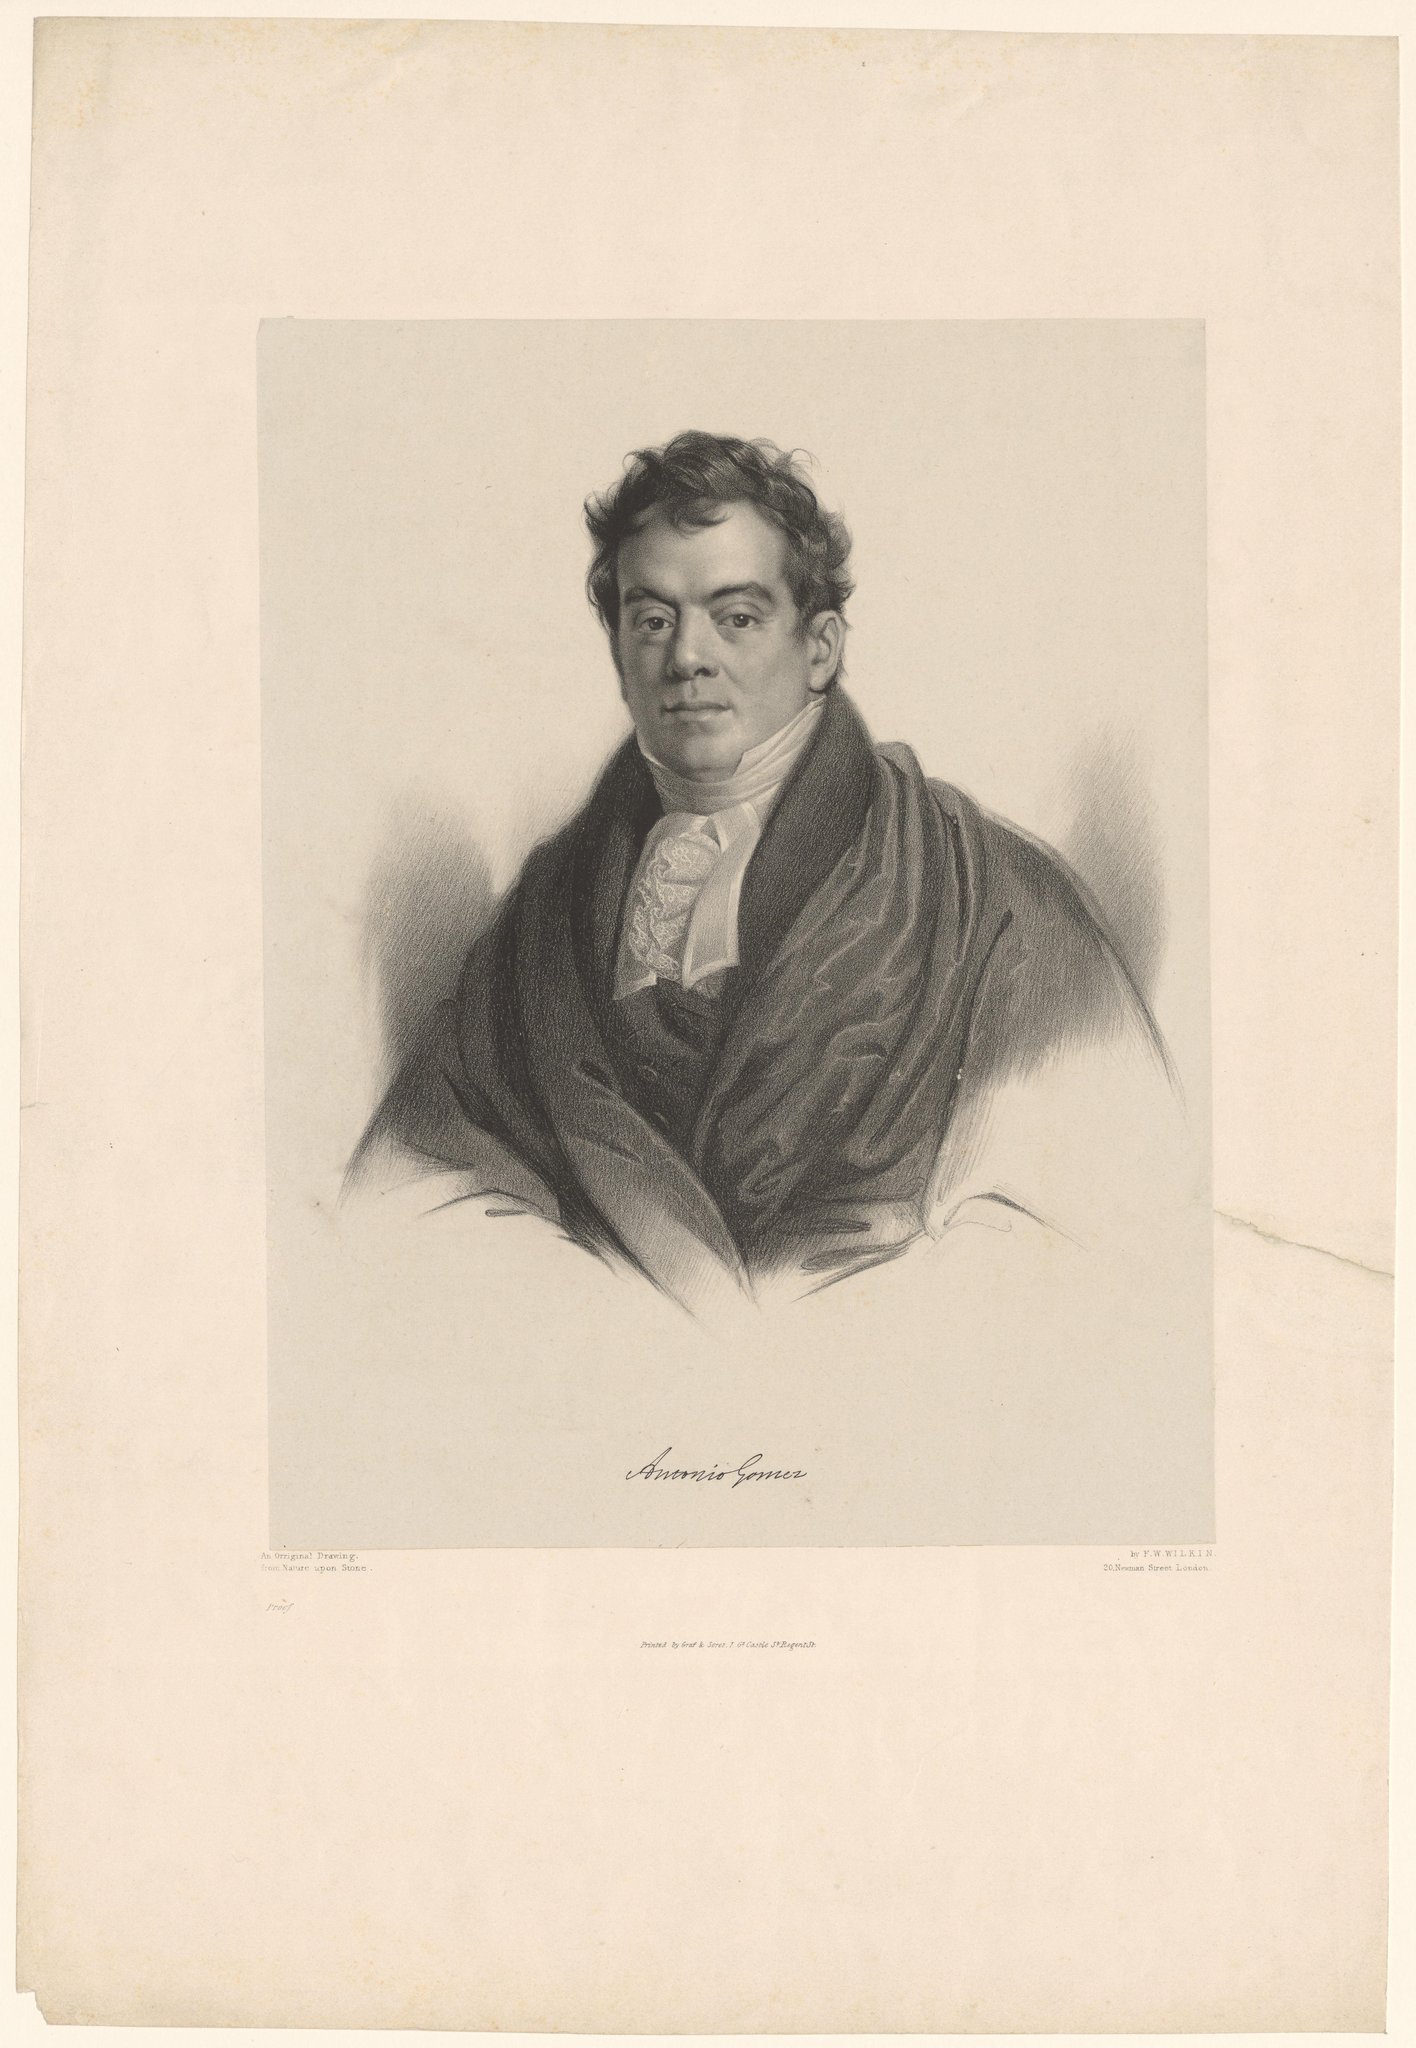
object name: print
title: Portret van Antonio Gomez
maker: frank w. wilkin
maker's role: print maker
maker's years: 1800-1842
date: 1810-1842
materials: paper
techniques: lithograph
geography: london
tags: adult man, historical persons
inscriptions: collector's mark: Lugt 2228